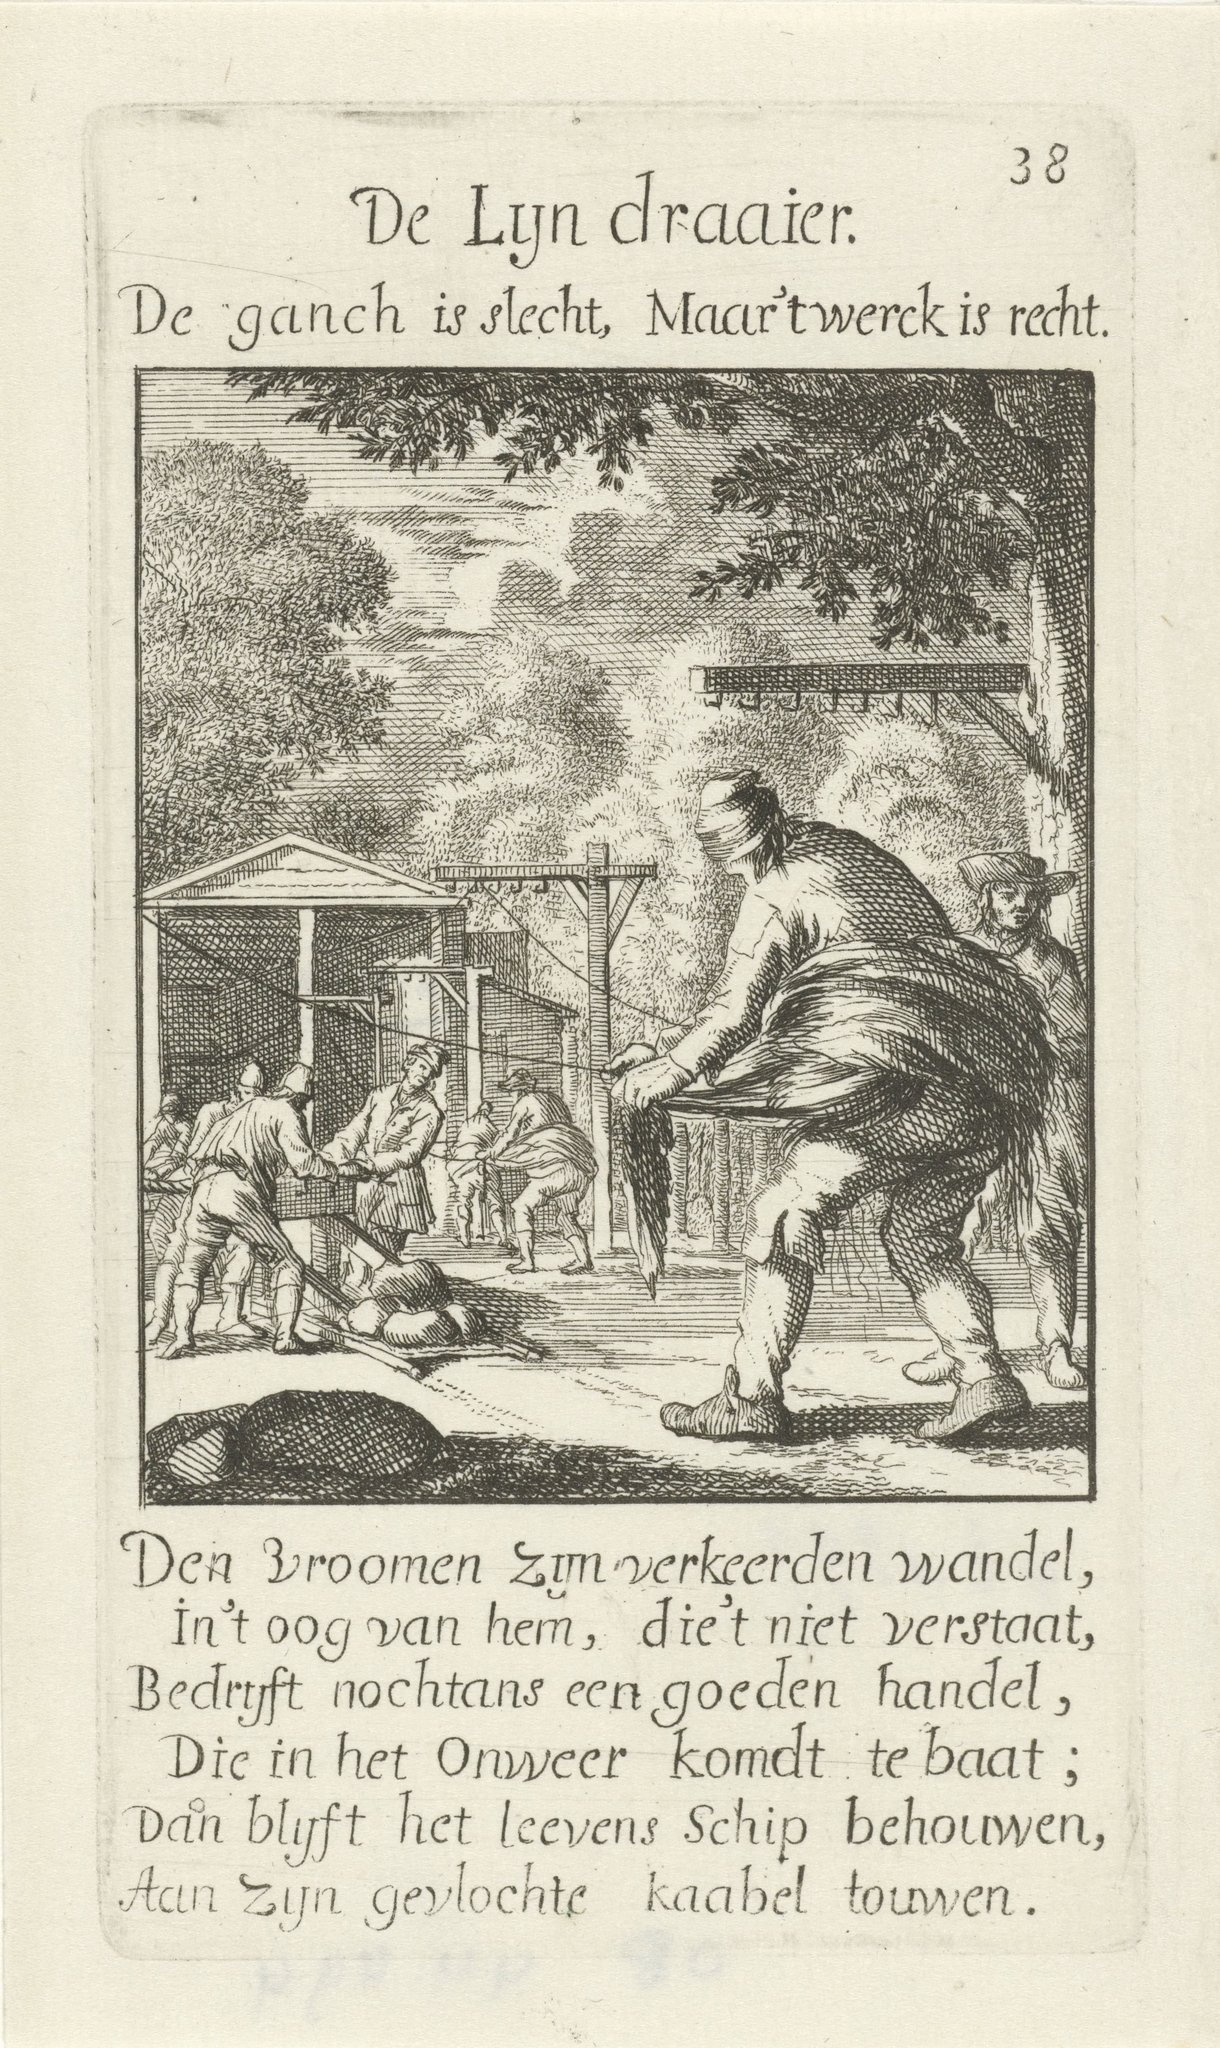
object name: print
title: De Lyn draaier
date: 1694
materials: paper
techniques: etching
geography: amsterdam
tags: rope-making, handicrafts, craftsman at work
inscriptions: collector's mark: Lugt 2228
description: Maakt deel uit van de 100-delige serie beroepsprenten van Jan en Caspar Luyken, getiteld: Het menselyk bedryf. S.l.s.n., 1694 (eerste druk).